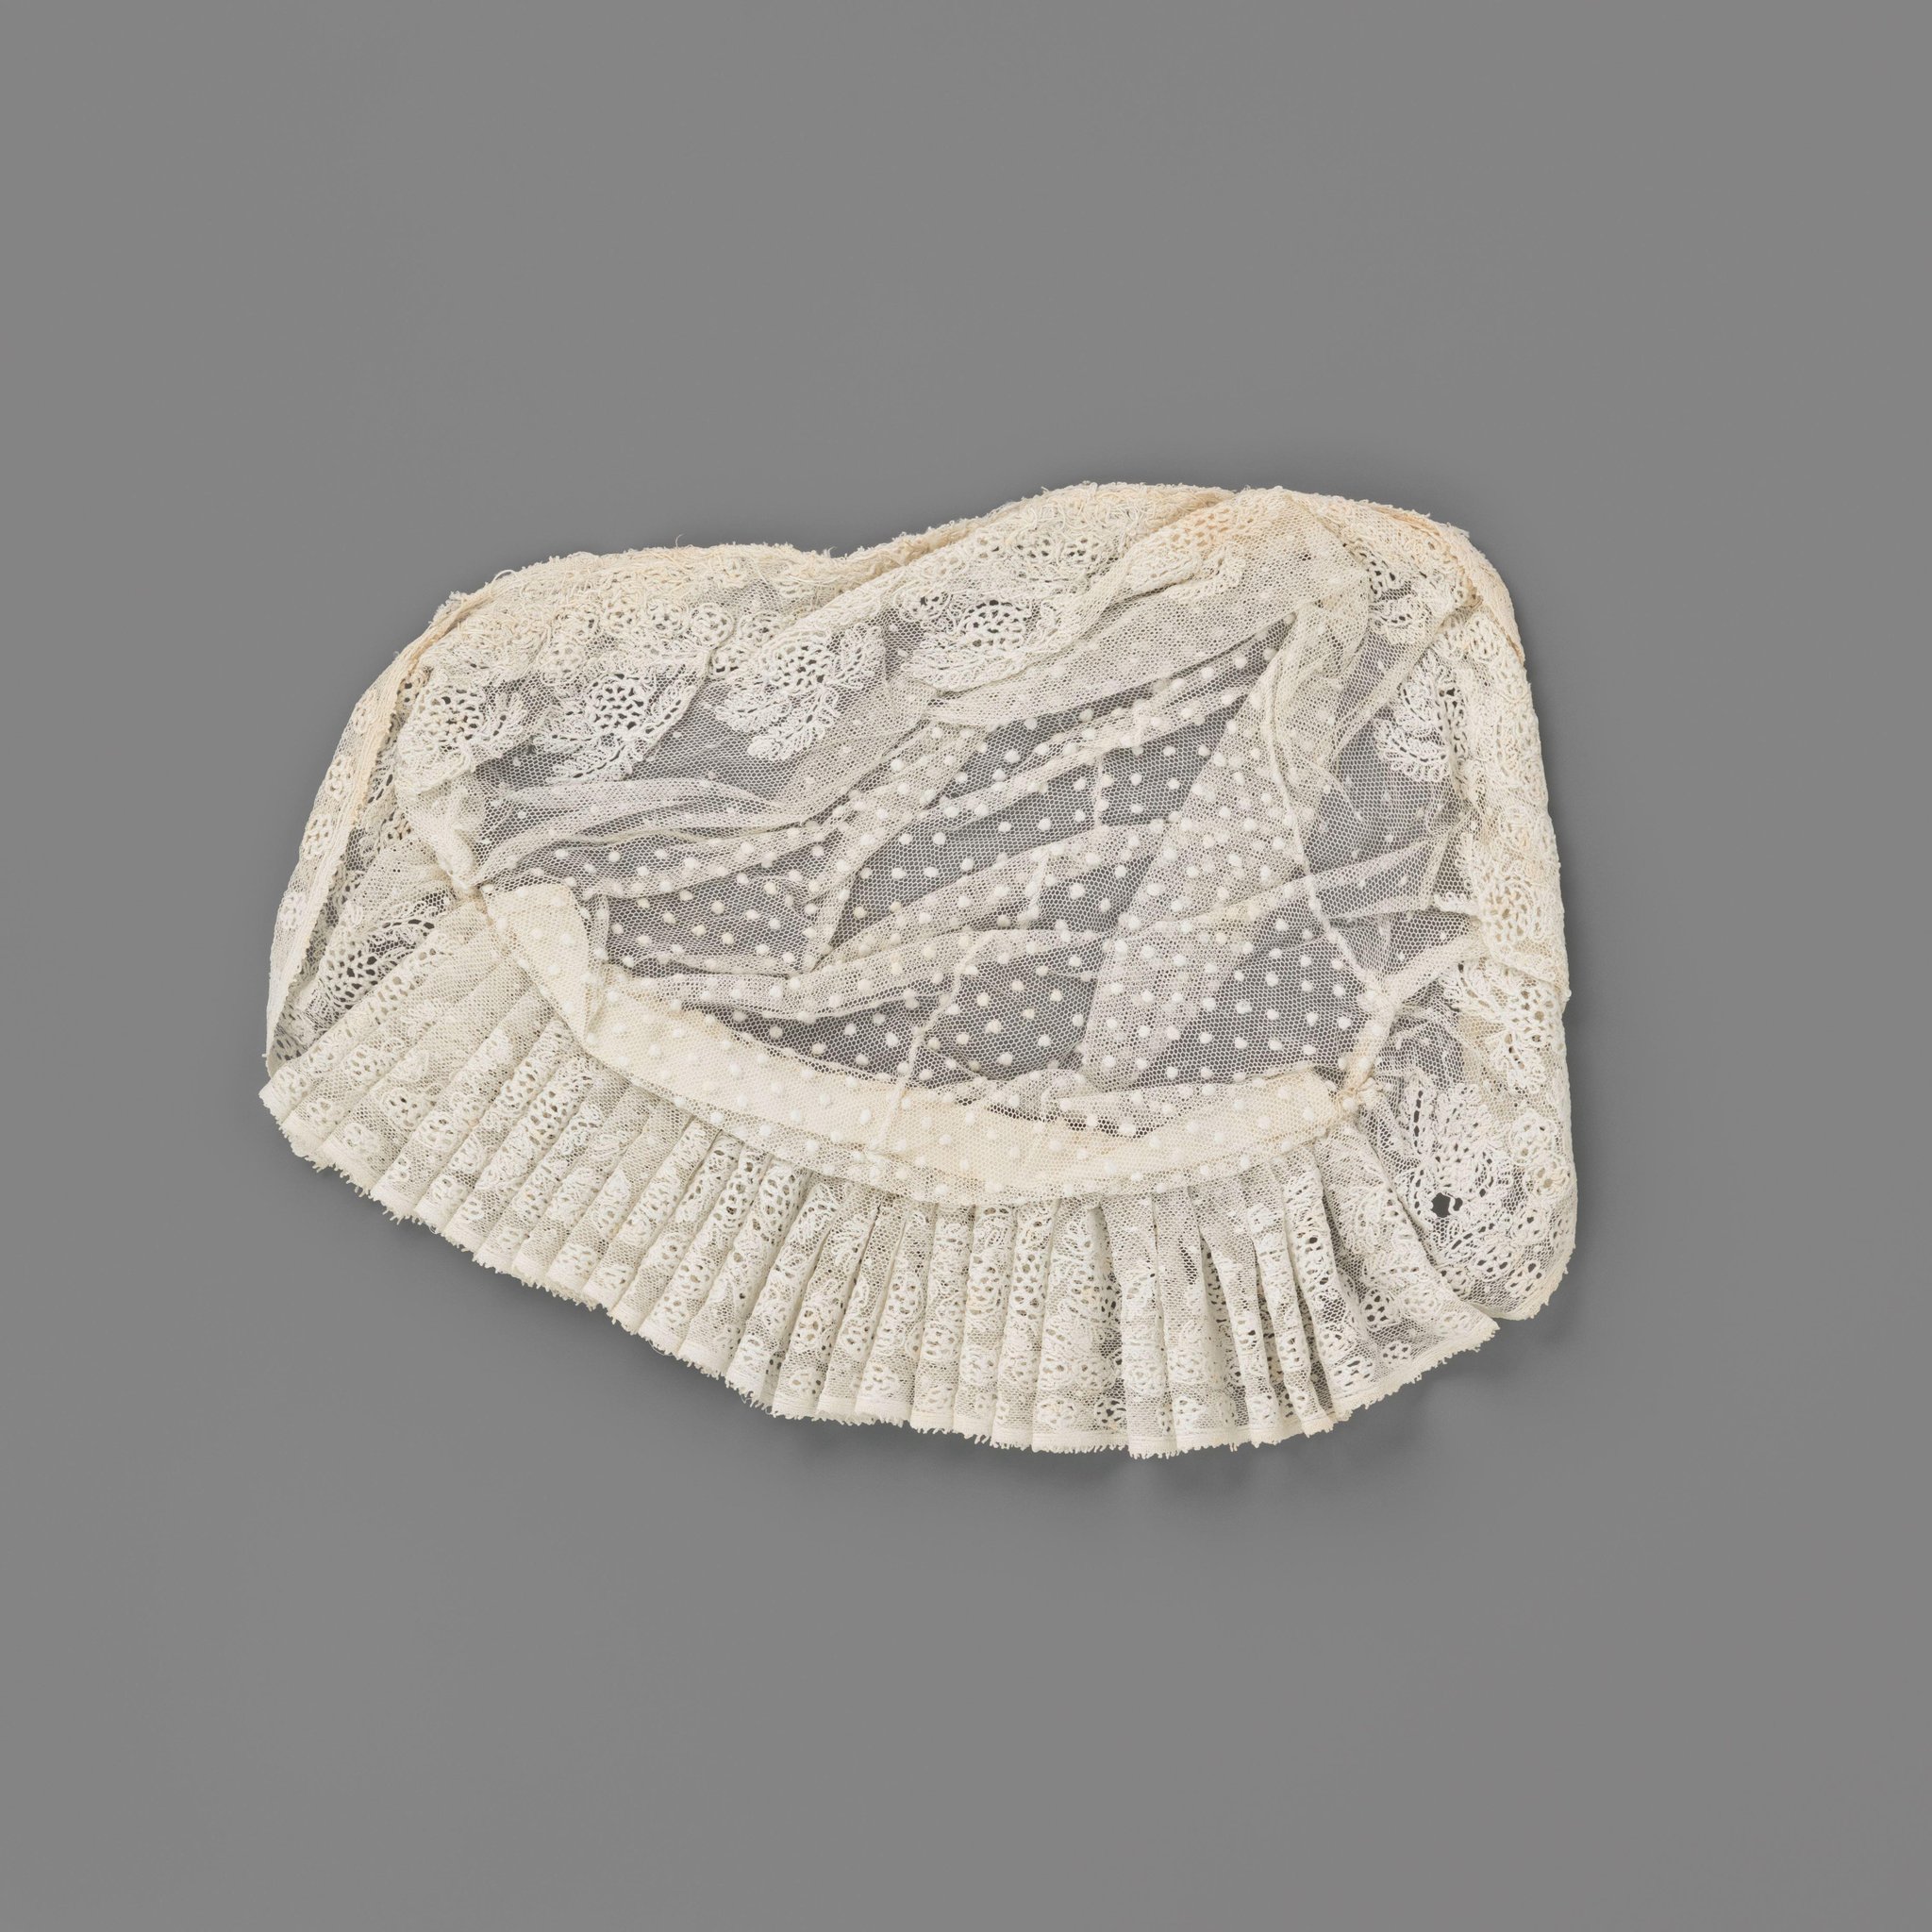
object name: womenswear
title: Muts van tule met strook doorgestopte tule die langs het voorhoofd geplooid is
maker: Anonymous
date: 1800-1900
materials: linen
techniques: material, embroidered, weave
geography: friesland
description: Muts van tule met strook doorgestopte tule. De bol van met moesjes geborduurde tule is rondom afgezet met een strook doorgestopte tule. De tule is langs het voorhoofd geplooid.